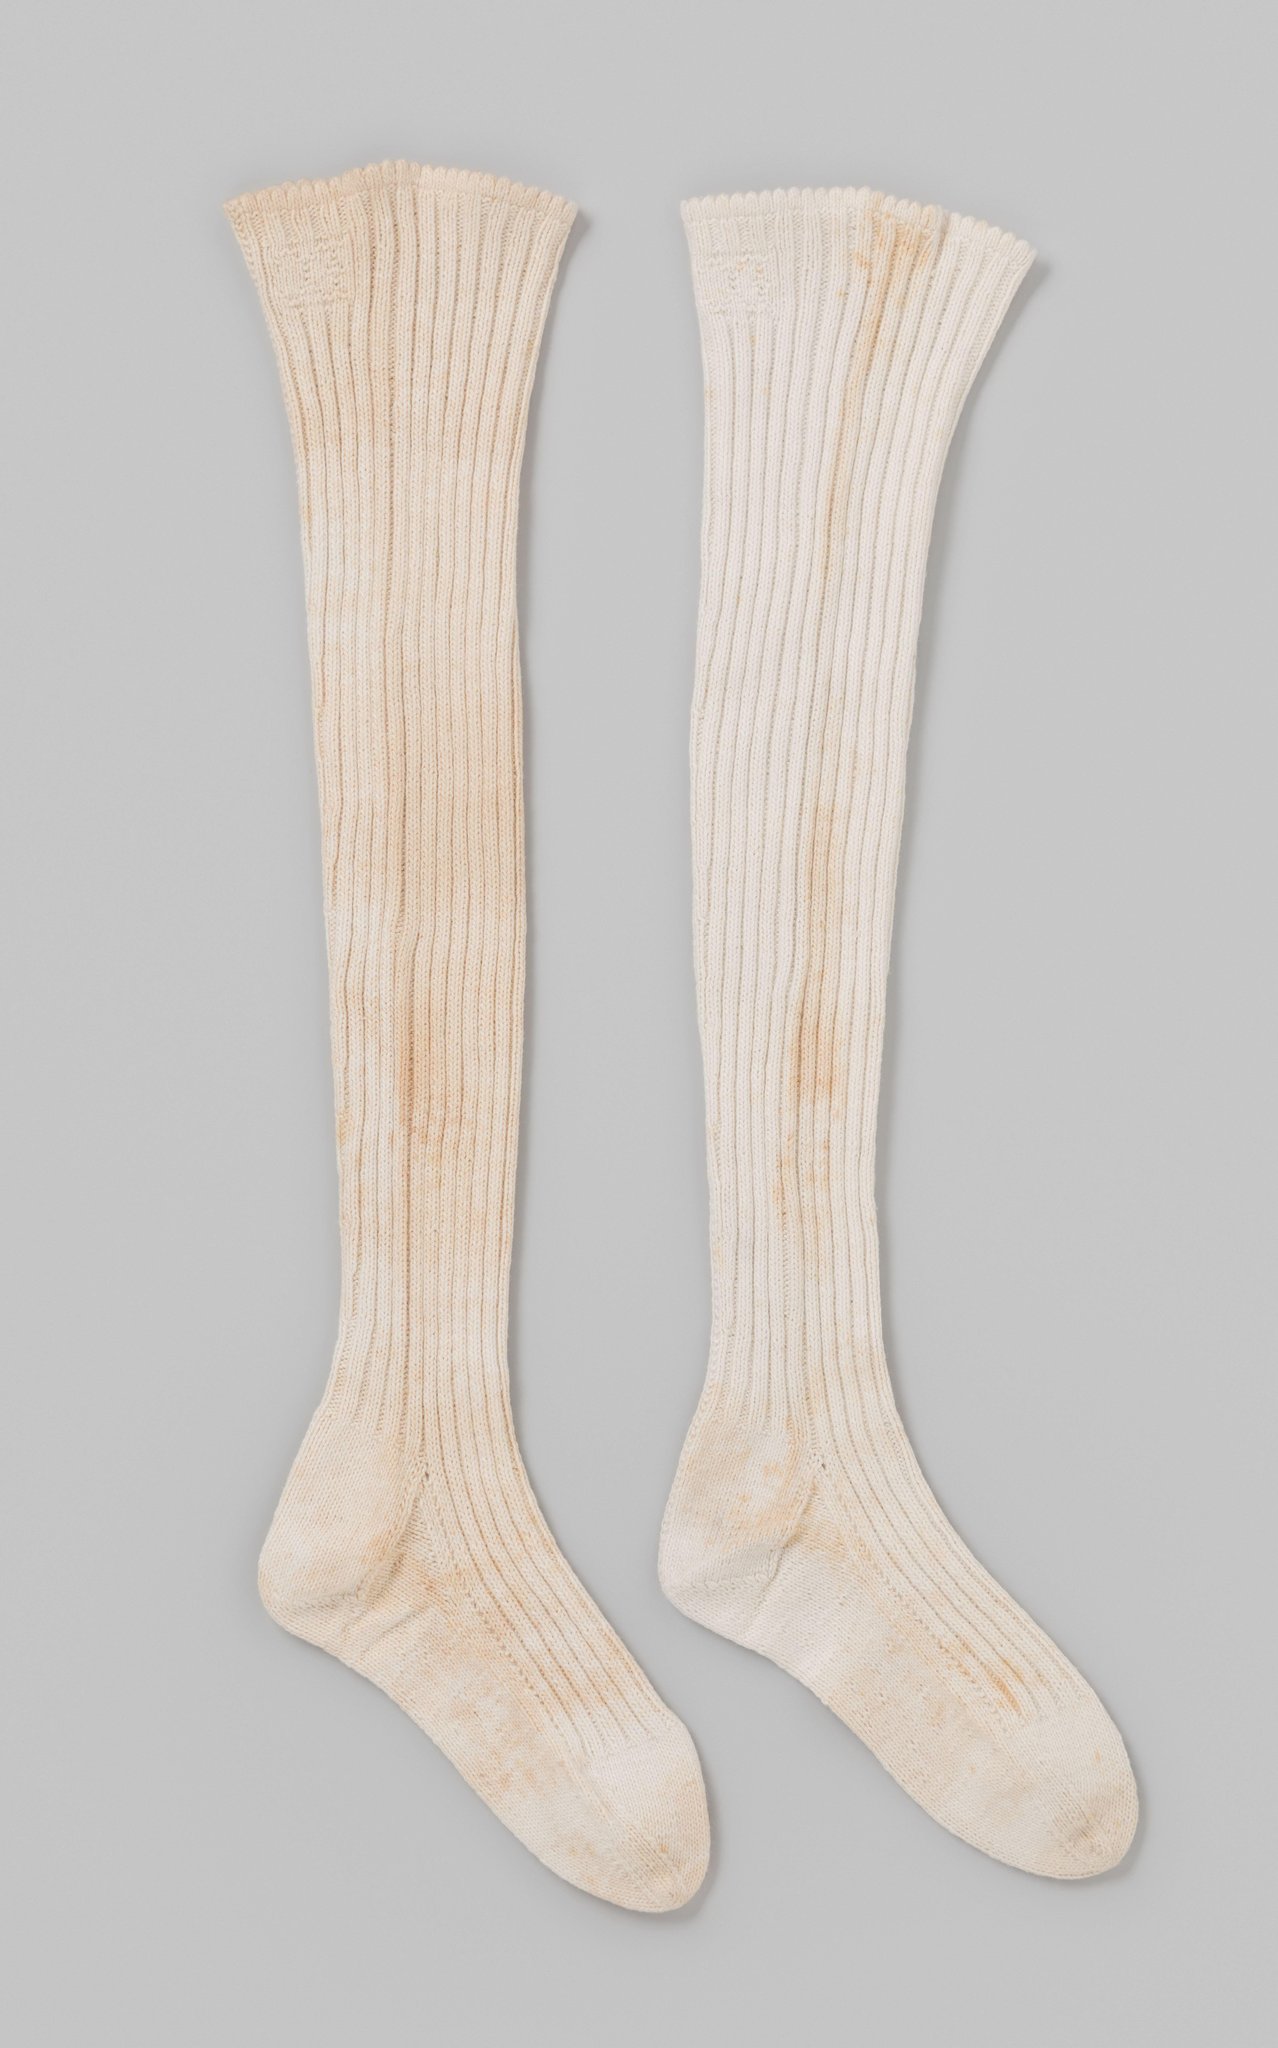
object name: stocking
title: Kous van gebreide witte katoen in ribsteek, kindermaat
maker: Anonymous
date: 1900-1920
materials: cotton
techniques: knitting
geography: netherlands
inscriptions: mark: ‘'M 2'’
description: Kous van gebreide witte katoen in ribsteek, kindermaat. Gemerkt: 'M 2'.